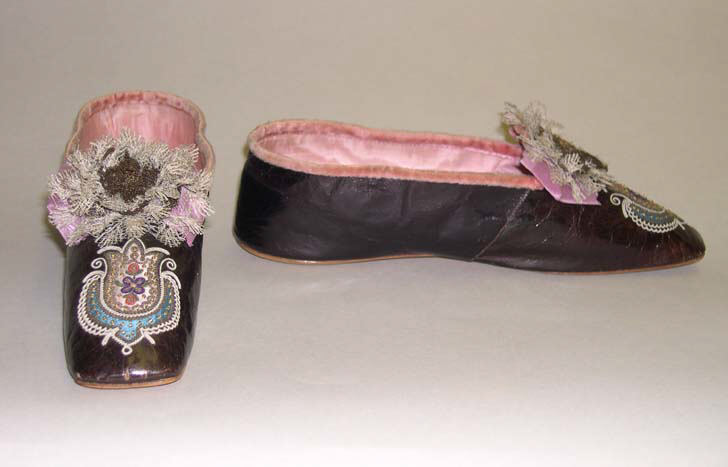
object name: slipper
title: Slippers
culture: british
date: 1863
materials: leather